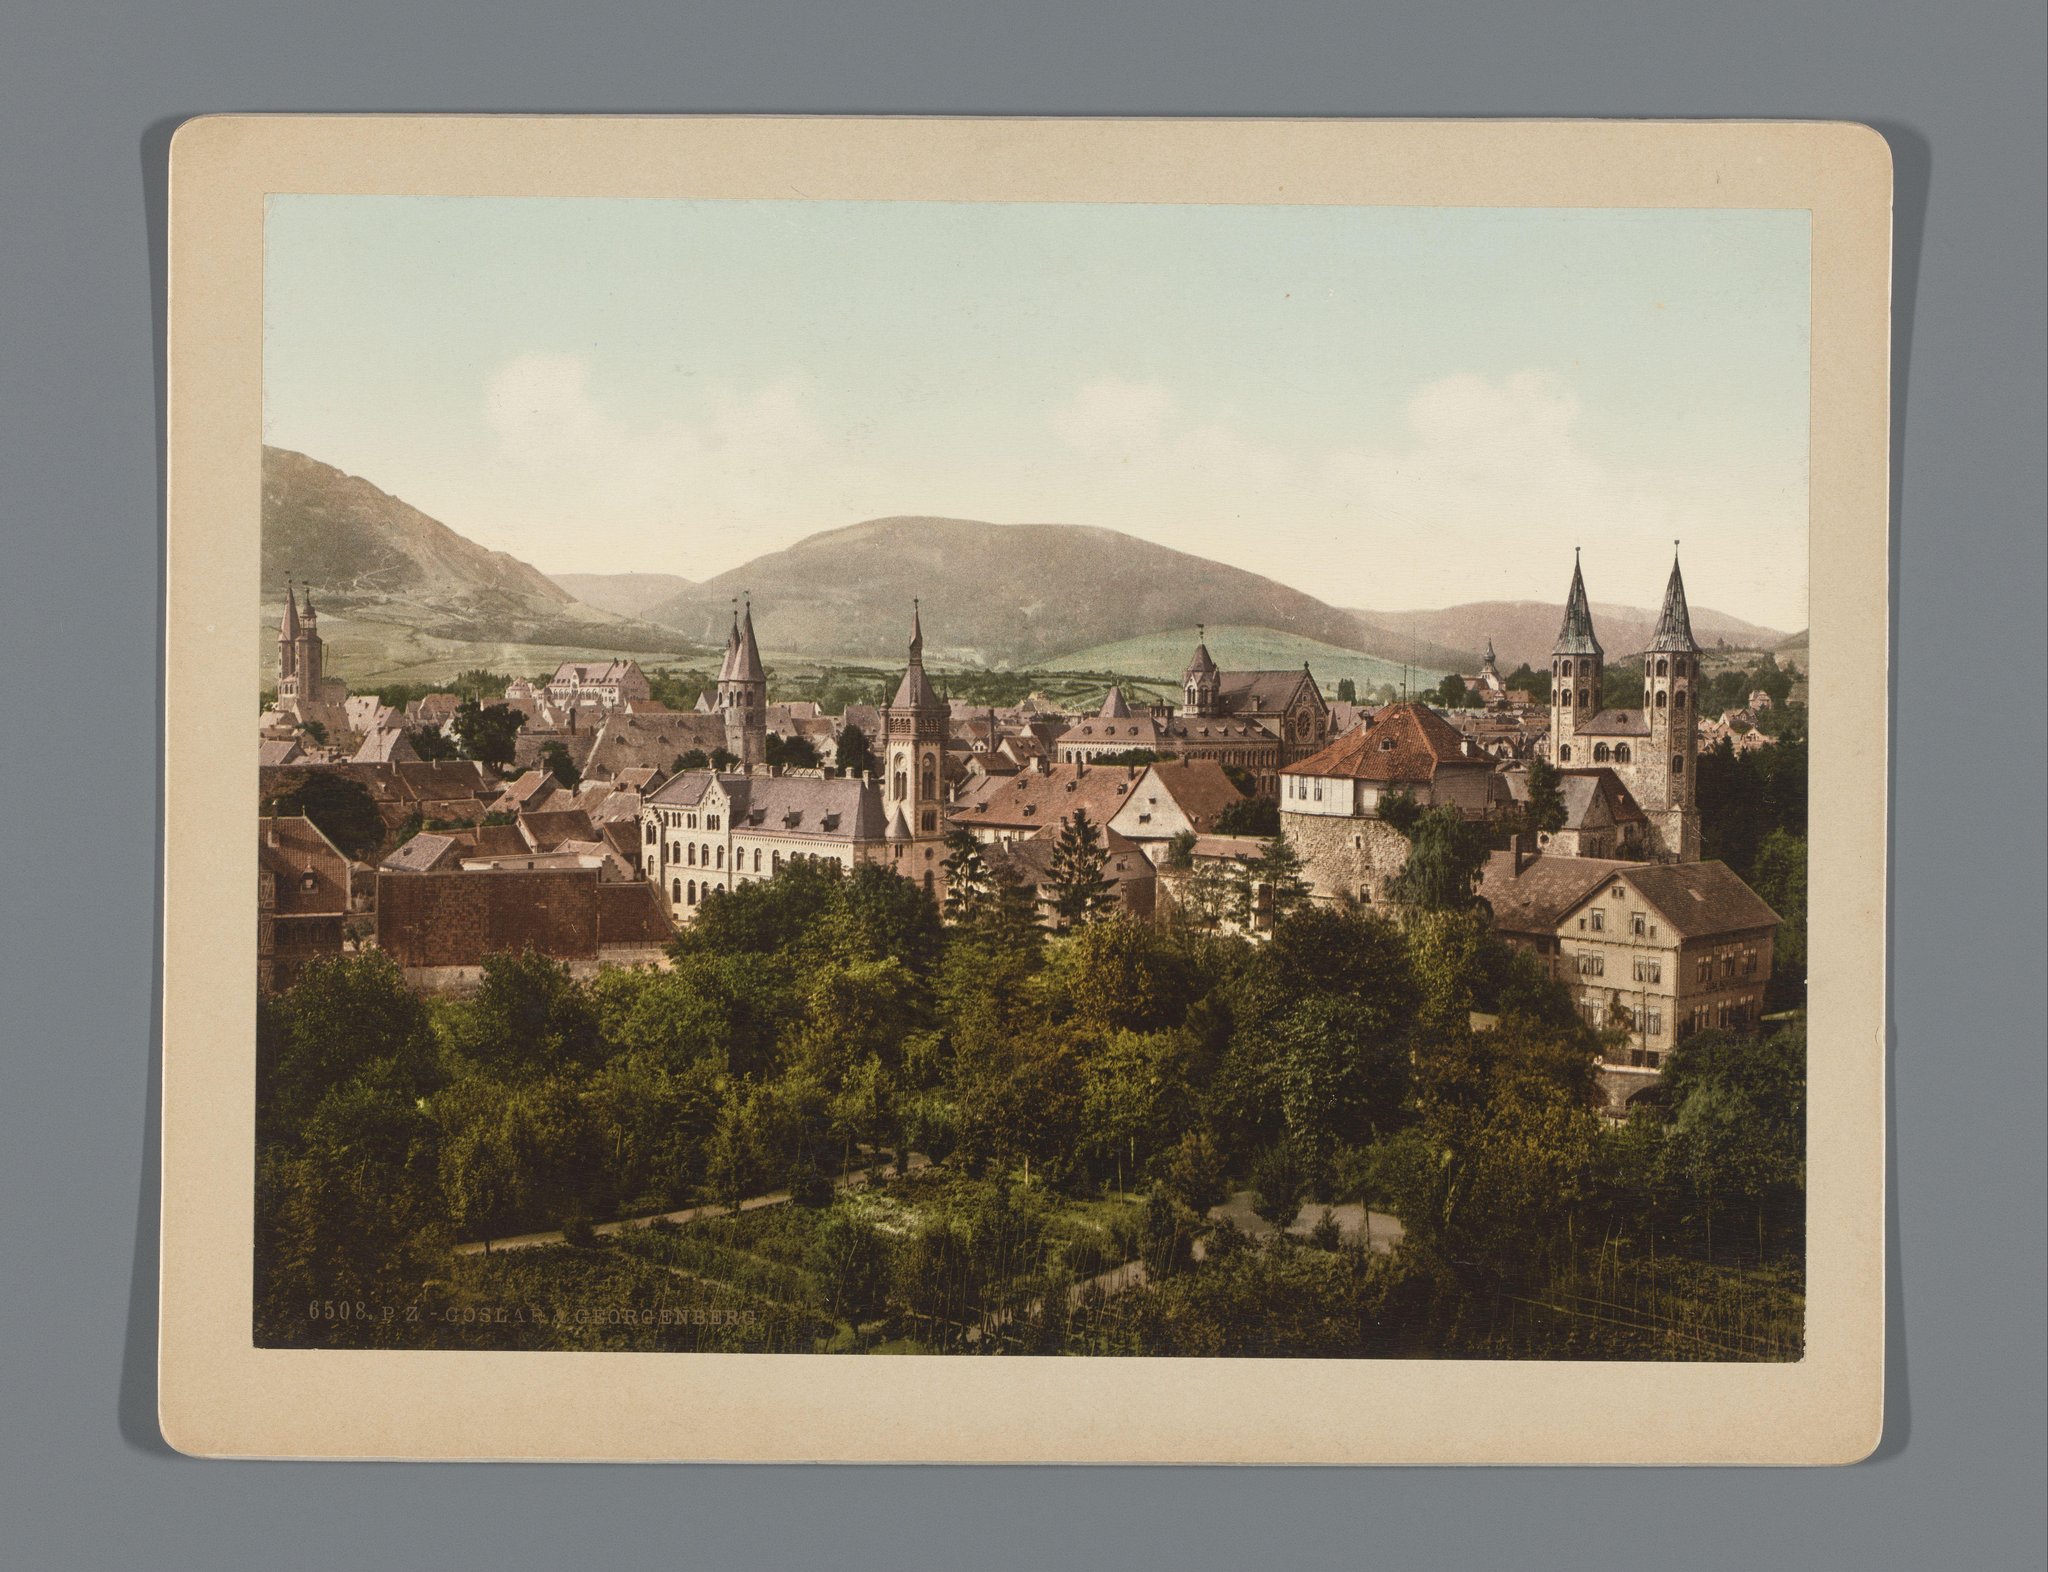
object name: photograph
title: Goslar & Georgenberg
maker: Anonymous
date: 1880-1920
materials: cardboard, photographic process, photographic support